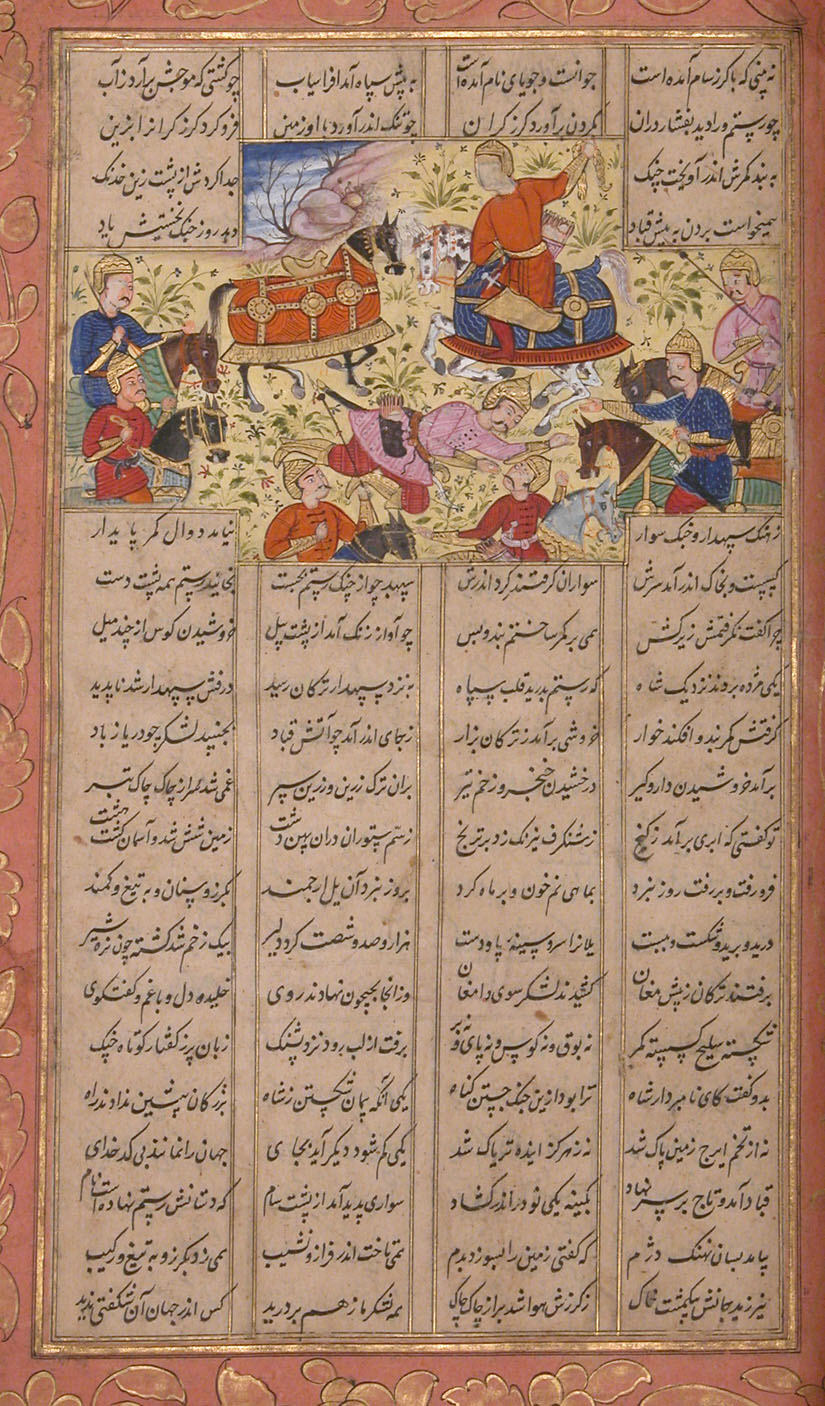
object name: illustrated manuscript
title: Shahnama (Book of Kings) of Firdausi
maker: abu'l qasim firdausi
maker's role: author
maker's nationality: iranian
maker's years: 935-1020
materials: gold, ink, paper, silver, watercolor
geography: india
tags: poetry,men,horses